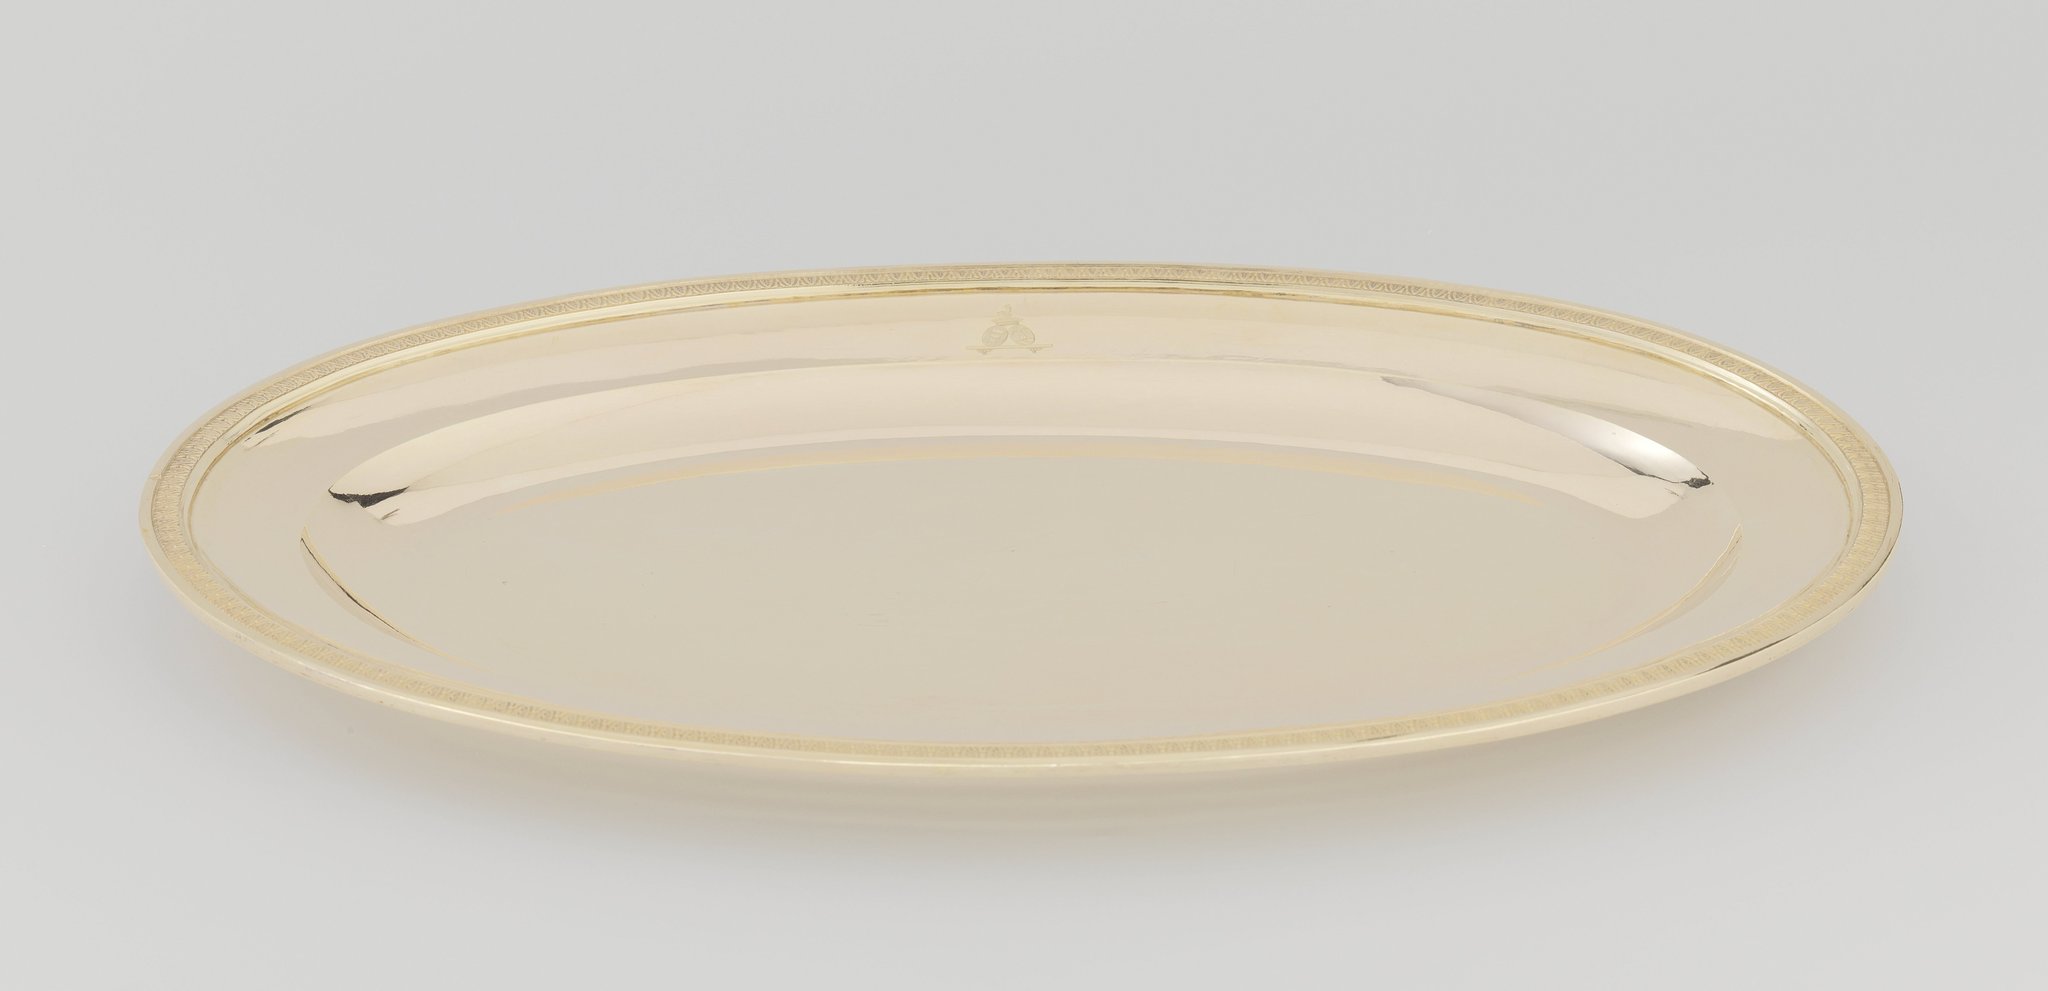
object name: platter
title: Oval dish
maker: jean baptiste claude odiot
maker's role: jeweler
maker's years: 1763-1850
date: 1819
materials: silver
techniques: gilding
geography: paris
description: These items are part of an 140-piece service that belonged to Alexandra Vasilievna Engelhardt, a noblewoman at the Russian court. The renowned silversmith Odiot collaborated with the painter Prud’hon and the architect Cavelier. They proudly presented their models at the French national crafts exhibition in 1819. The large late Empire figures, like the kneeling angels supporting the soup tureen, are striking.